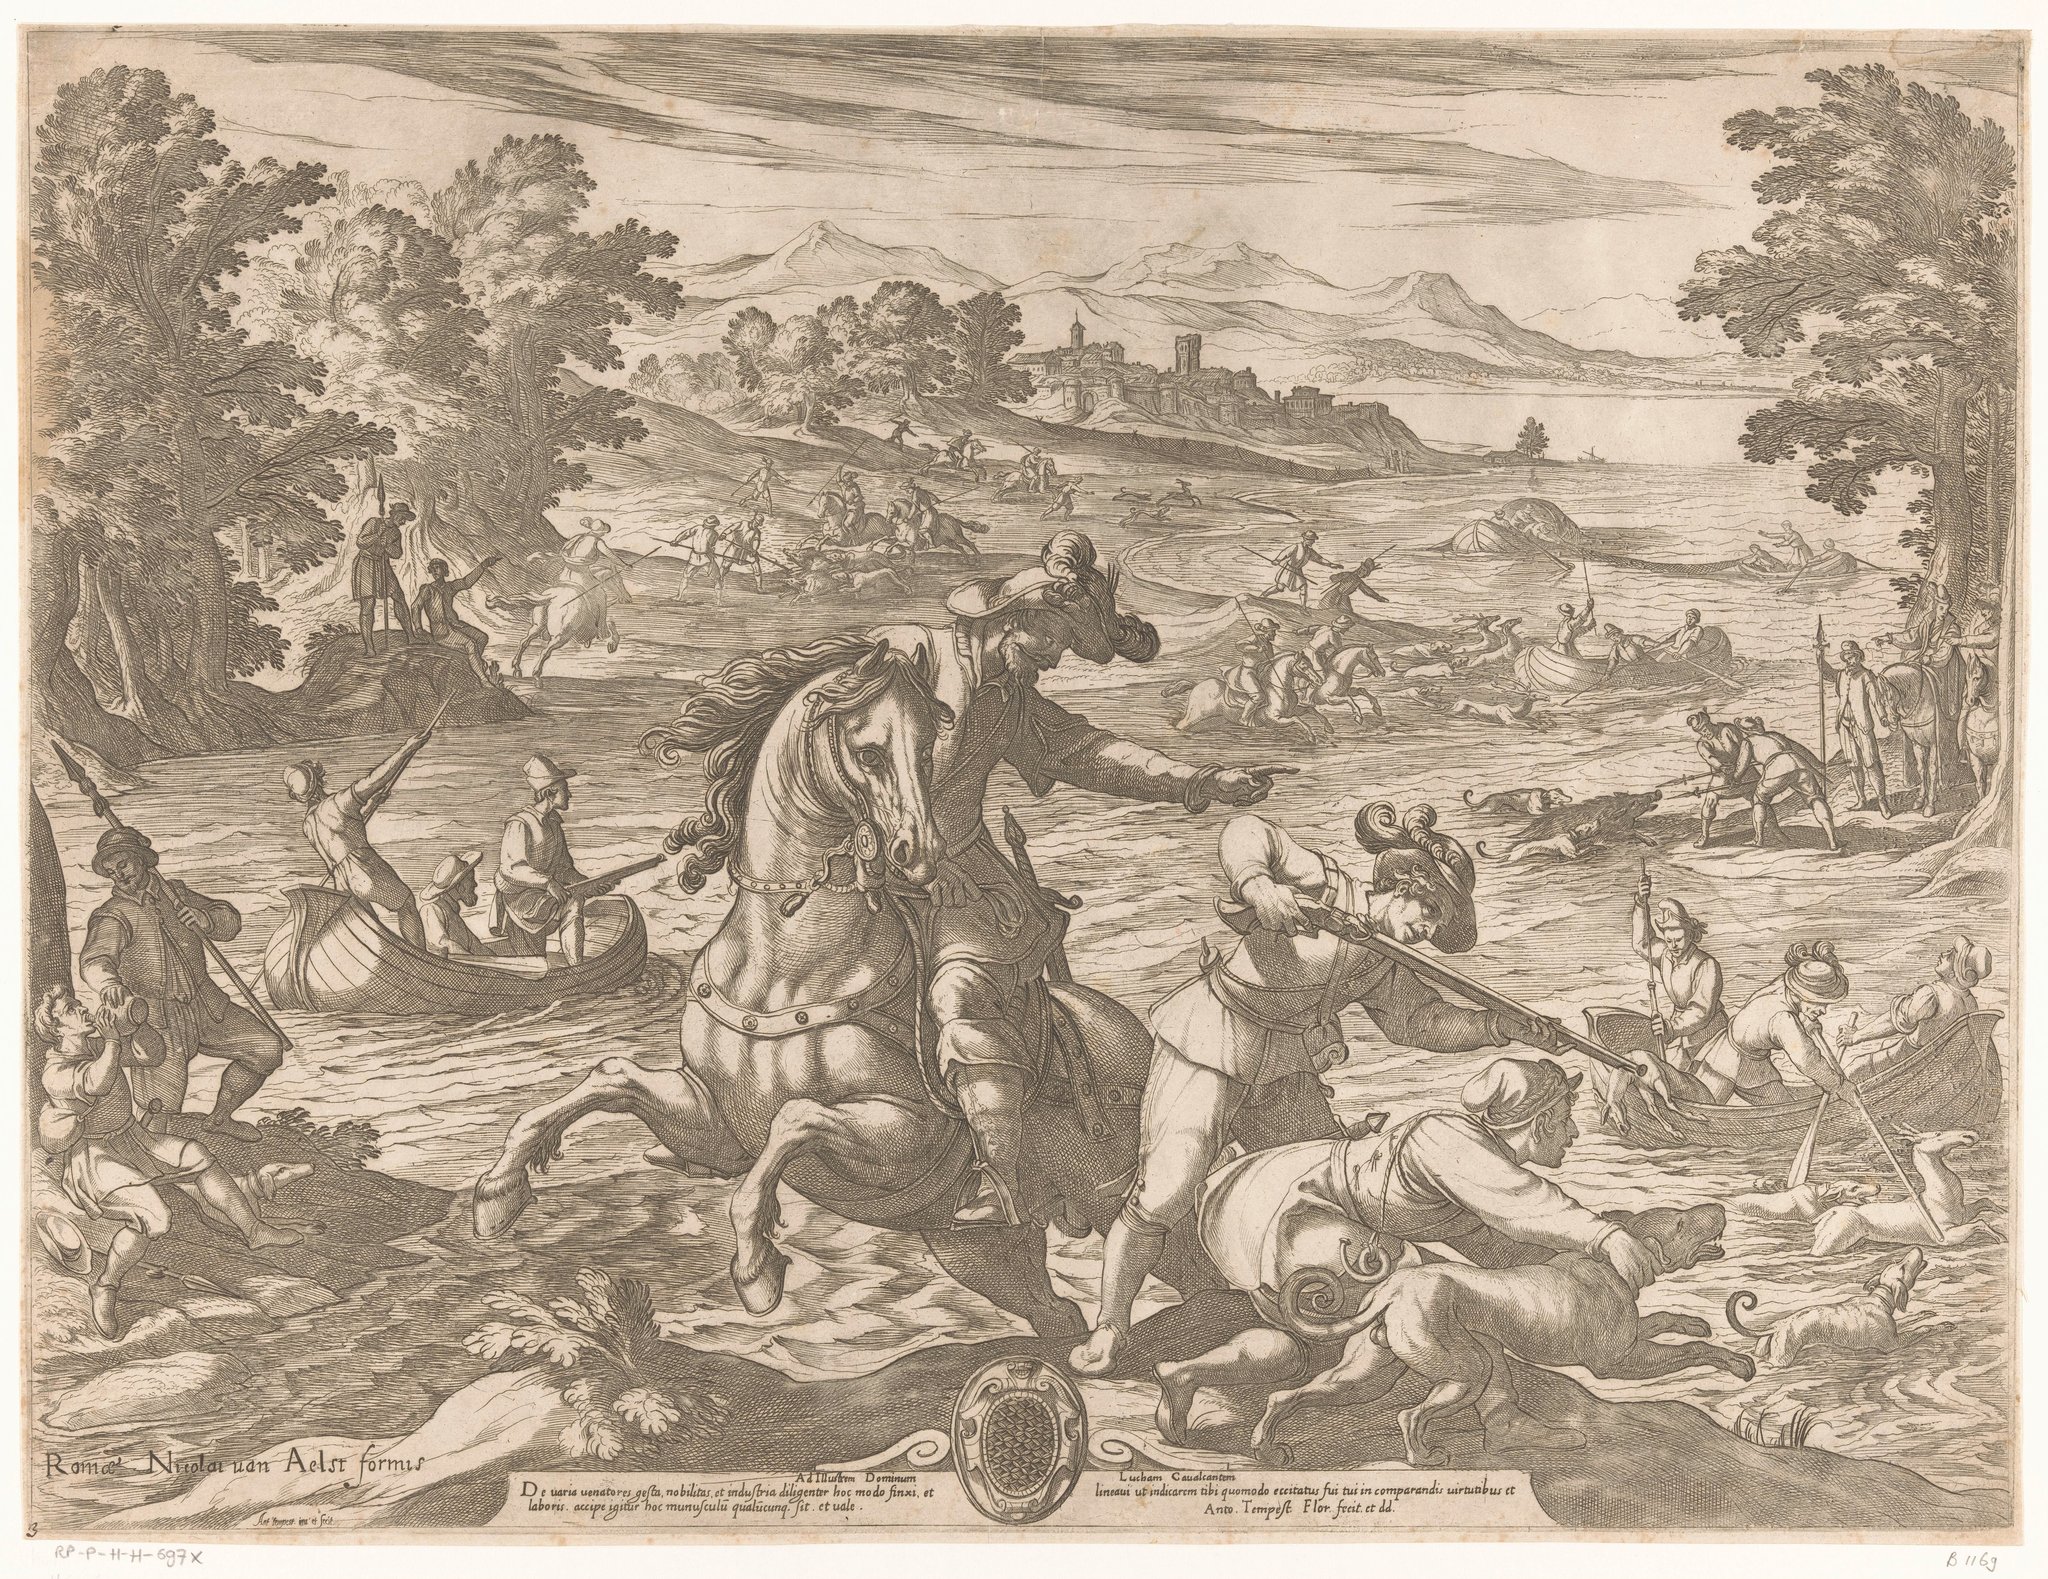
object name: print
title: Jacht op herten en everzwijnen in aanwezigheid van een dame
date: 1575-1613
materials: paper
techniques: etching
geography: rome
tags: coat of arms (symbol of sovereignty), stag-hunting, boar-hunting, hunter, hunters hunting (n.b.: in 1988-1990 this notation denoted the concept of 43c11421 'hunters resting during the hunt')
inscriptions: collector's mark: Lugt 11, collector's mark: ‘Hinloopen’, number: ‘3’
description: Rivierlandschap met jagers en jachthonden jagend op herten en everzwijnen. Rechts een dame te paard die toekijkt. Midden onder een wapenschild en cartouche met opdracht.